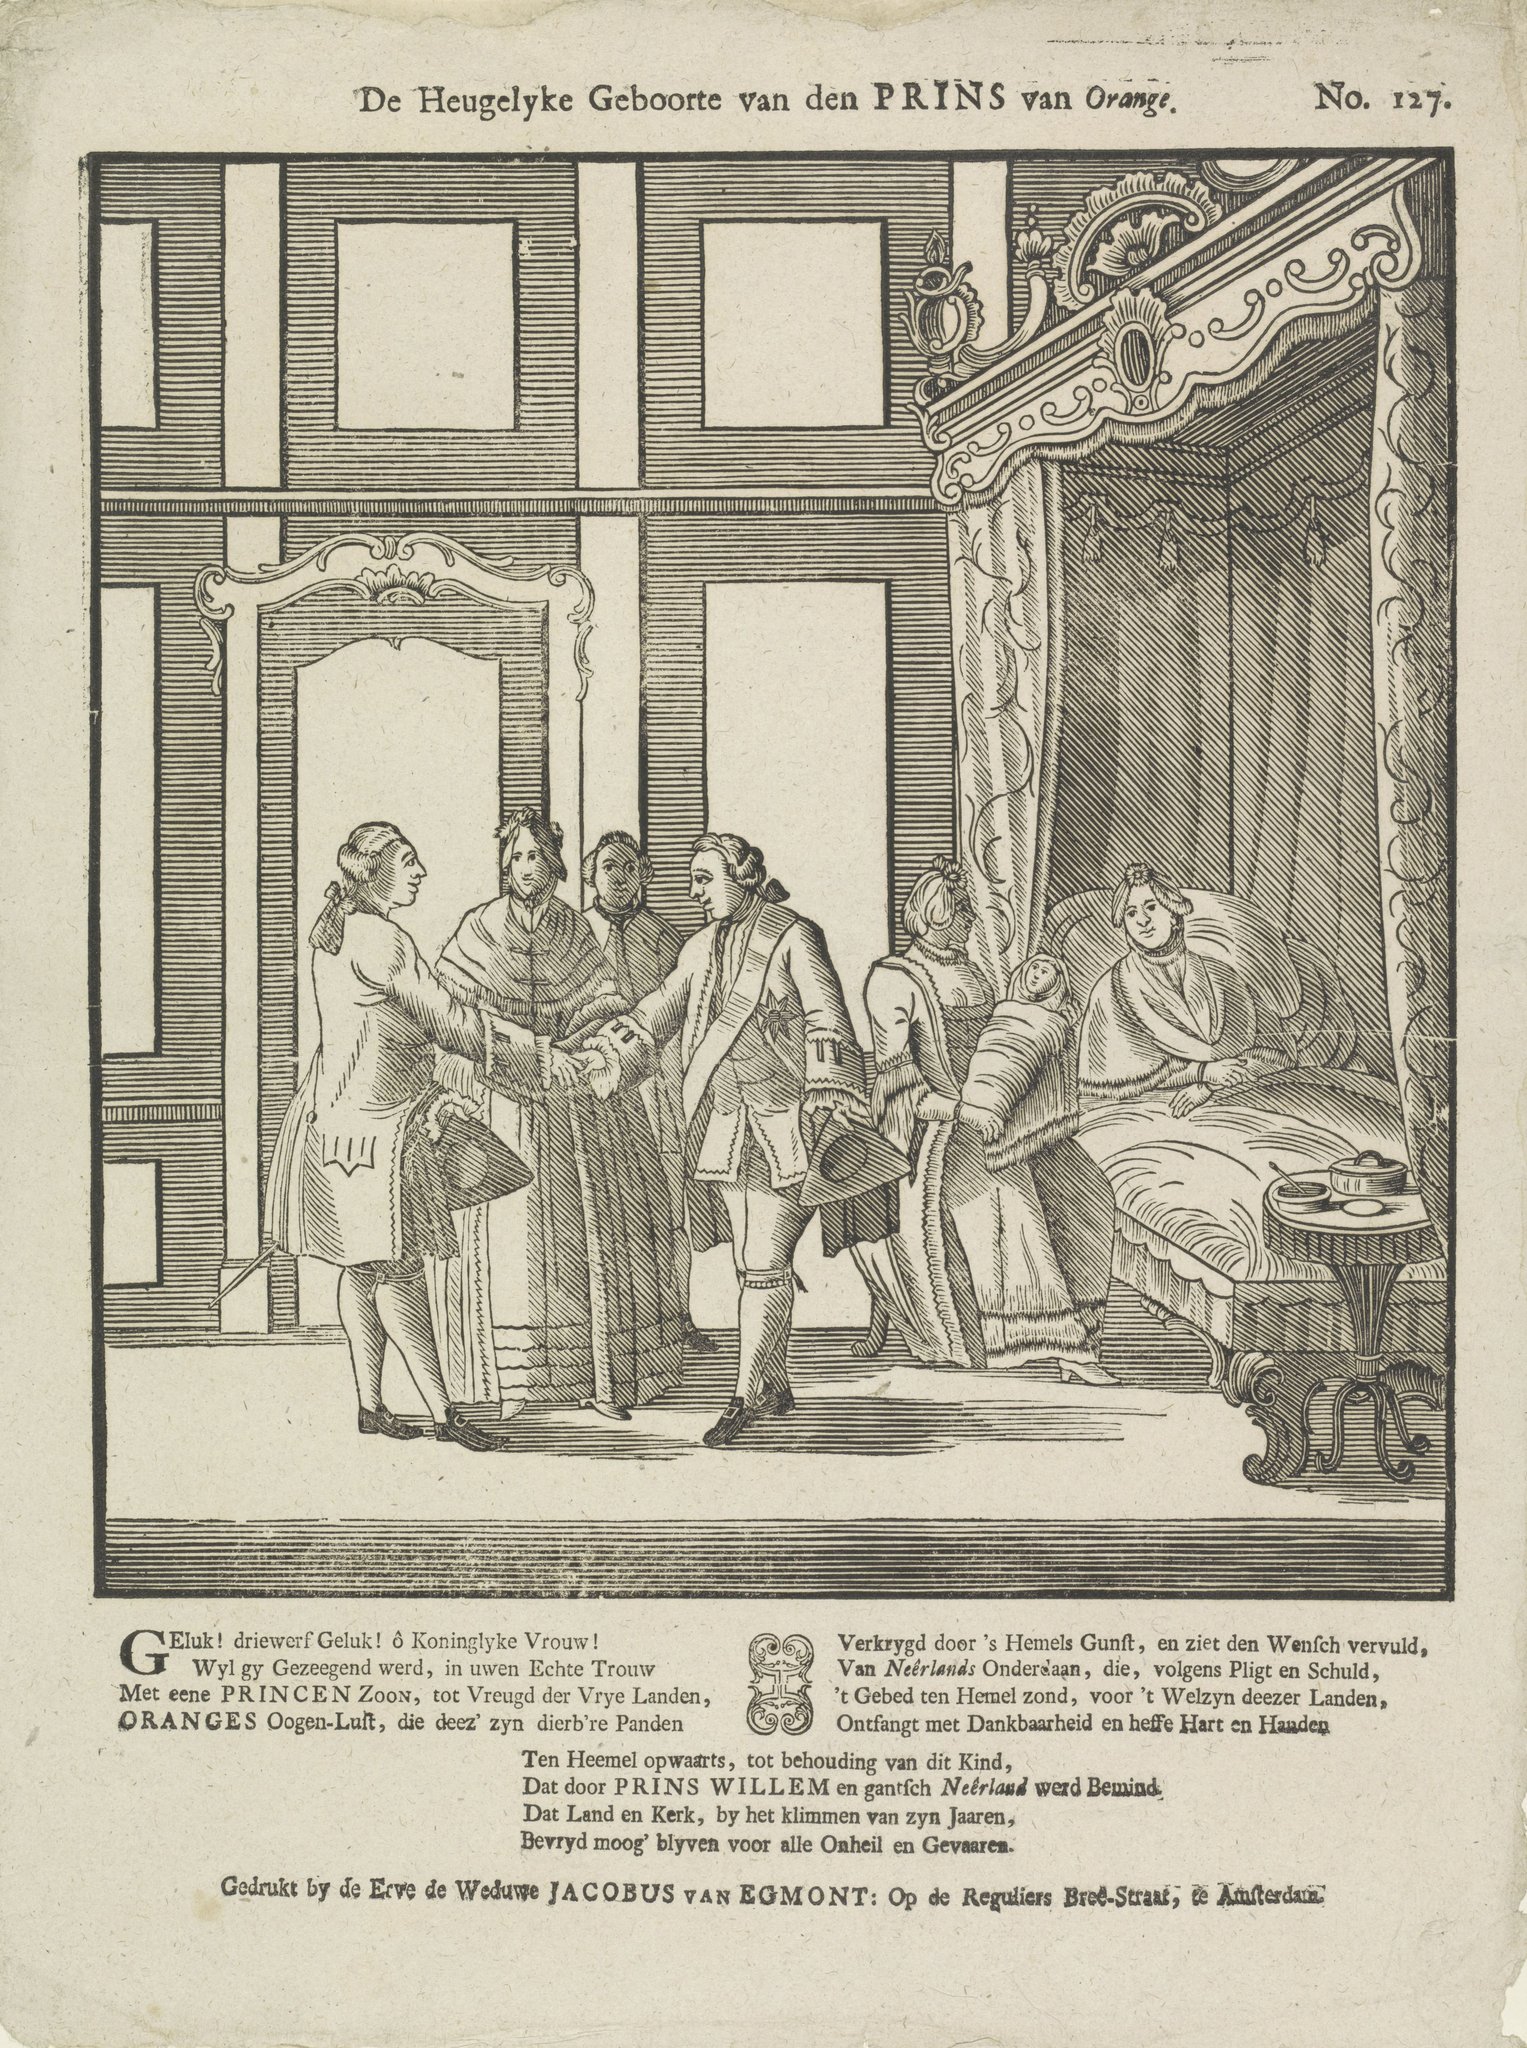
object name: print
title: De heugelyke geboorte van den Prins van Orange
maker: Anonymous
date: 1761-1804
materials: paper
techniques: letterpress printing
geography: amsterdam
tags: william v (prince of orange), the hague, berlin, william i of the netherlands, painter, wilhelmina of prussia (princess of orange), visiting the new mother, lying-in visit, infant, baby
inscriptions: collector's mark: Lugt 2760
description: Blad met grote voorstelling van een slaapkamer waar zojuist (vermoedelijk) Willem I Frederik geboren is. In de ruimte wordt zijn vader Willem V gefeliciteerd en zijn moeder Wilhelmina van Pruisen ligt in bed. Onder de voorstelling een twaalfregelig vers in drie kolommen. Genummerd rechtsboven: No. 127.